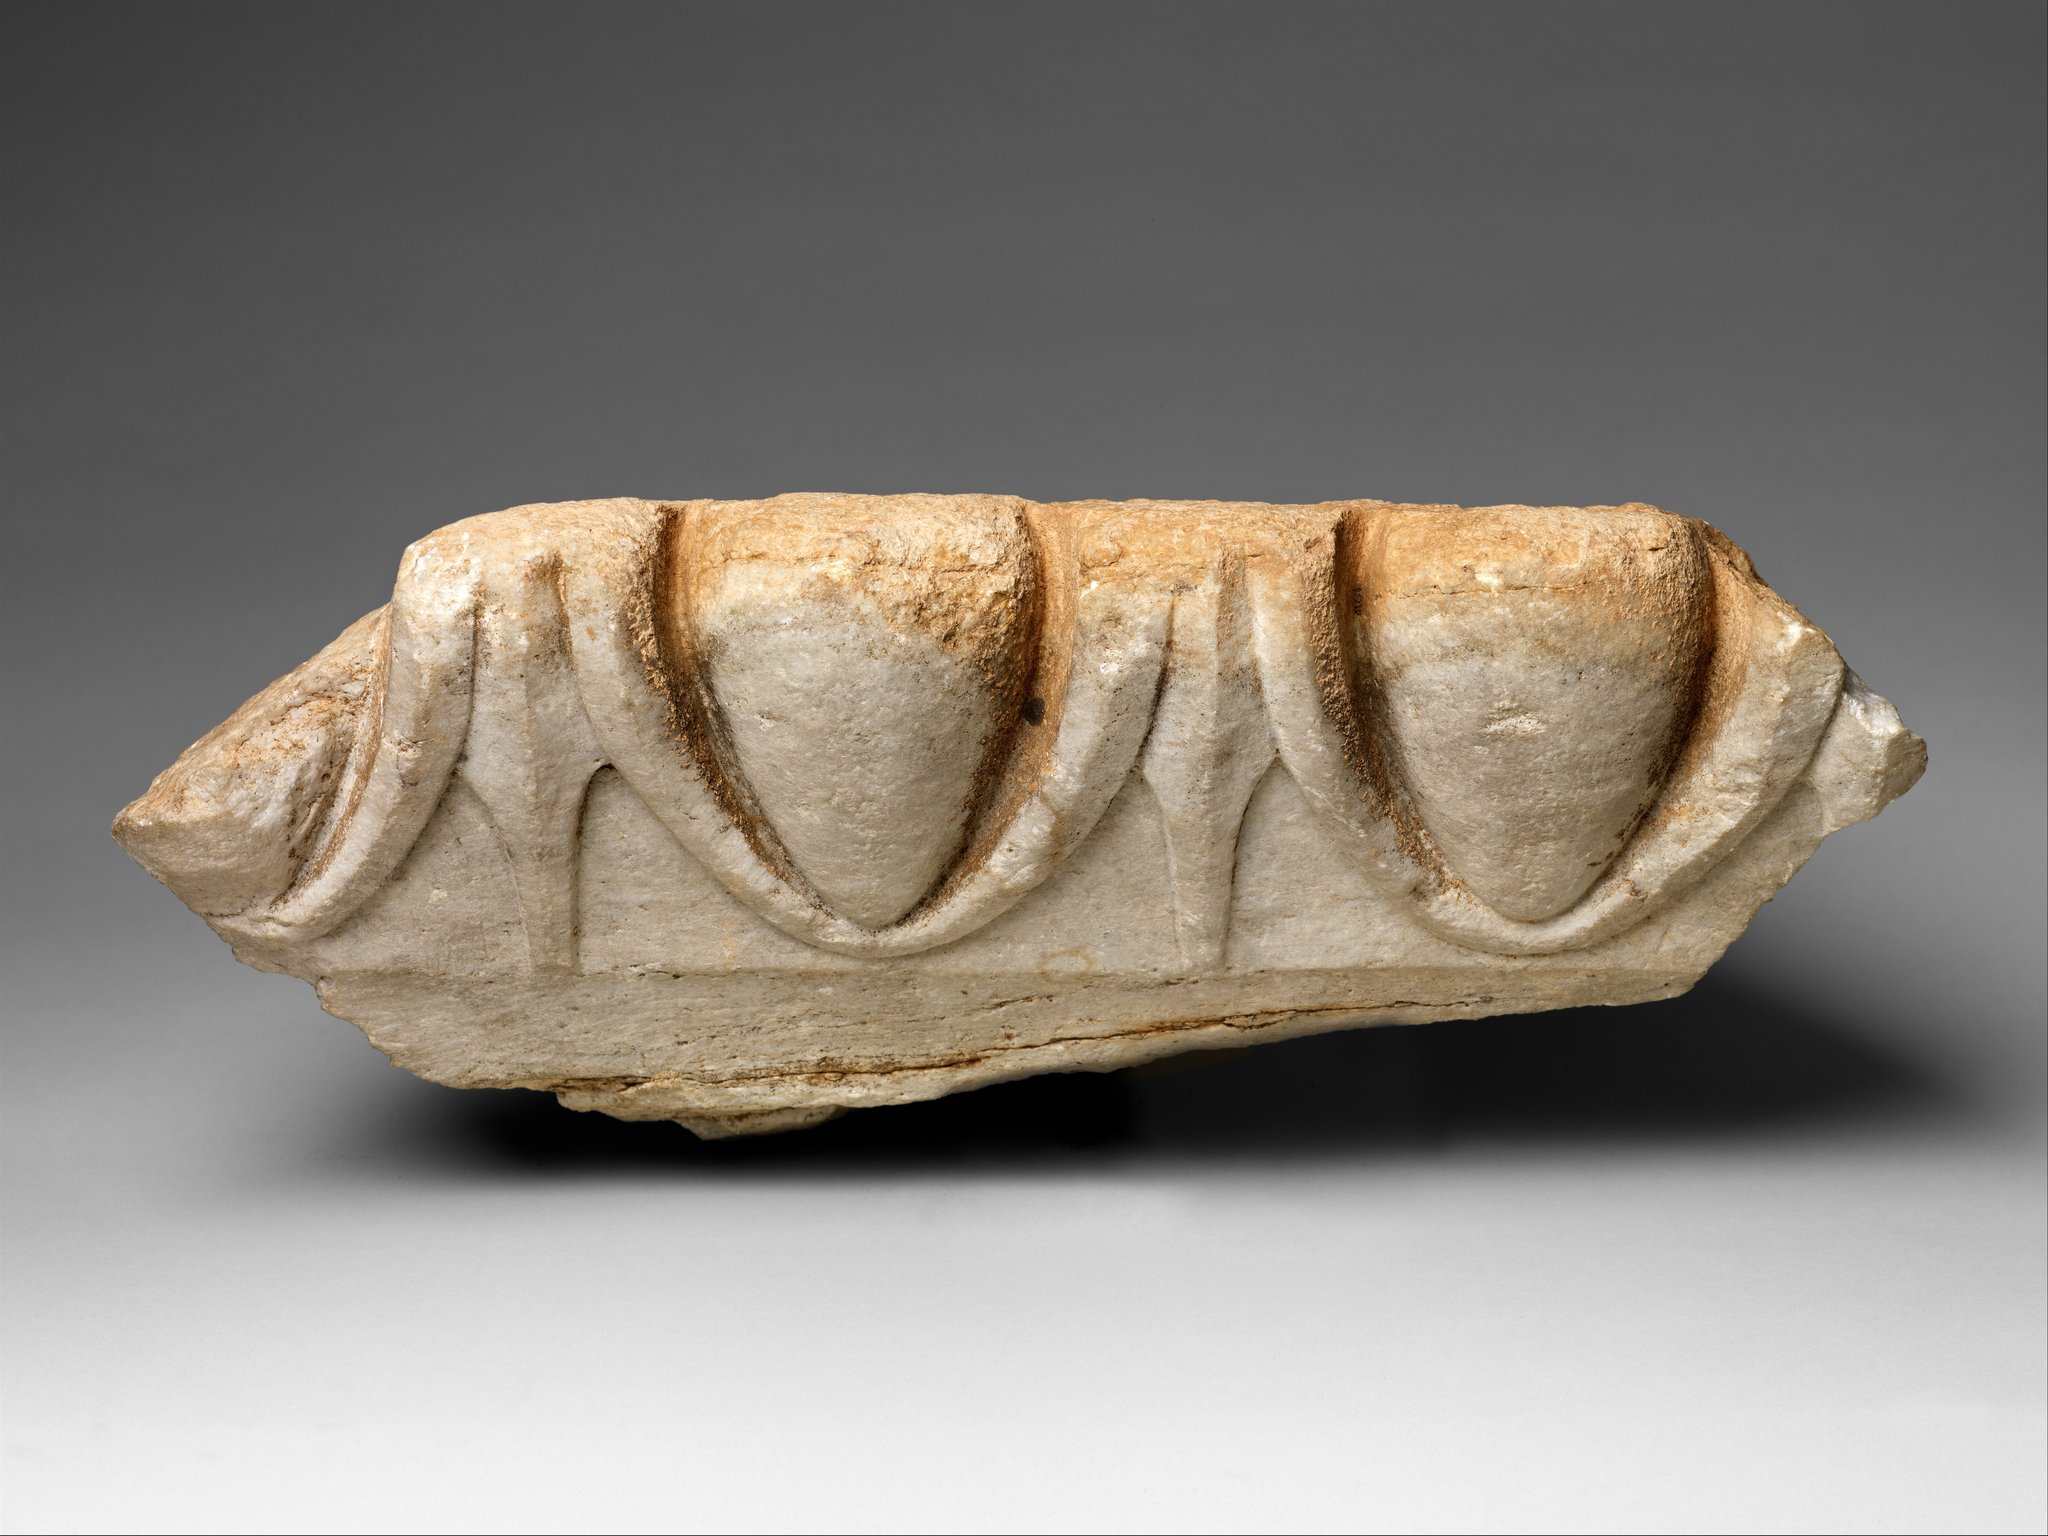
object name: architectural fragment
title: Marble fragment of an Ionic column capital from the Temple of Artemis at Sardis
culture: greek or roman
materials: marble